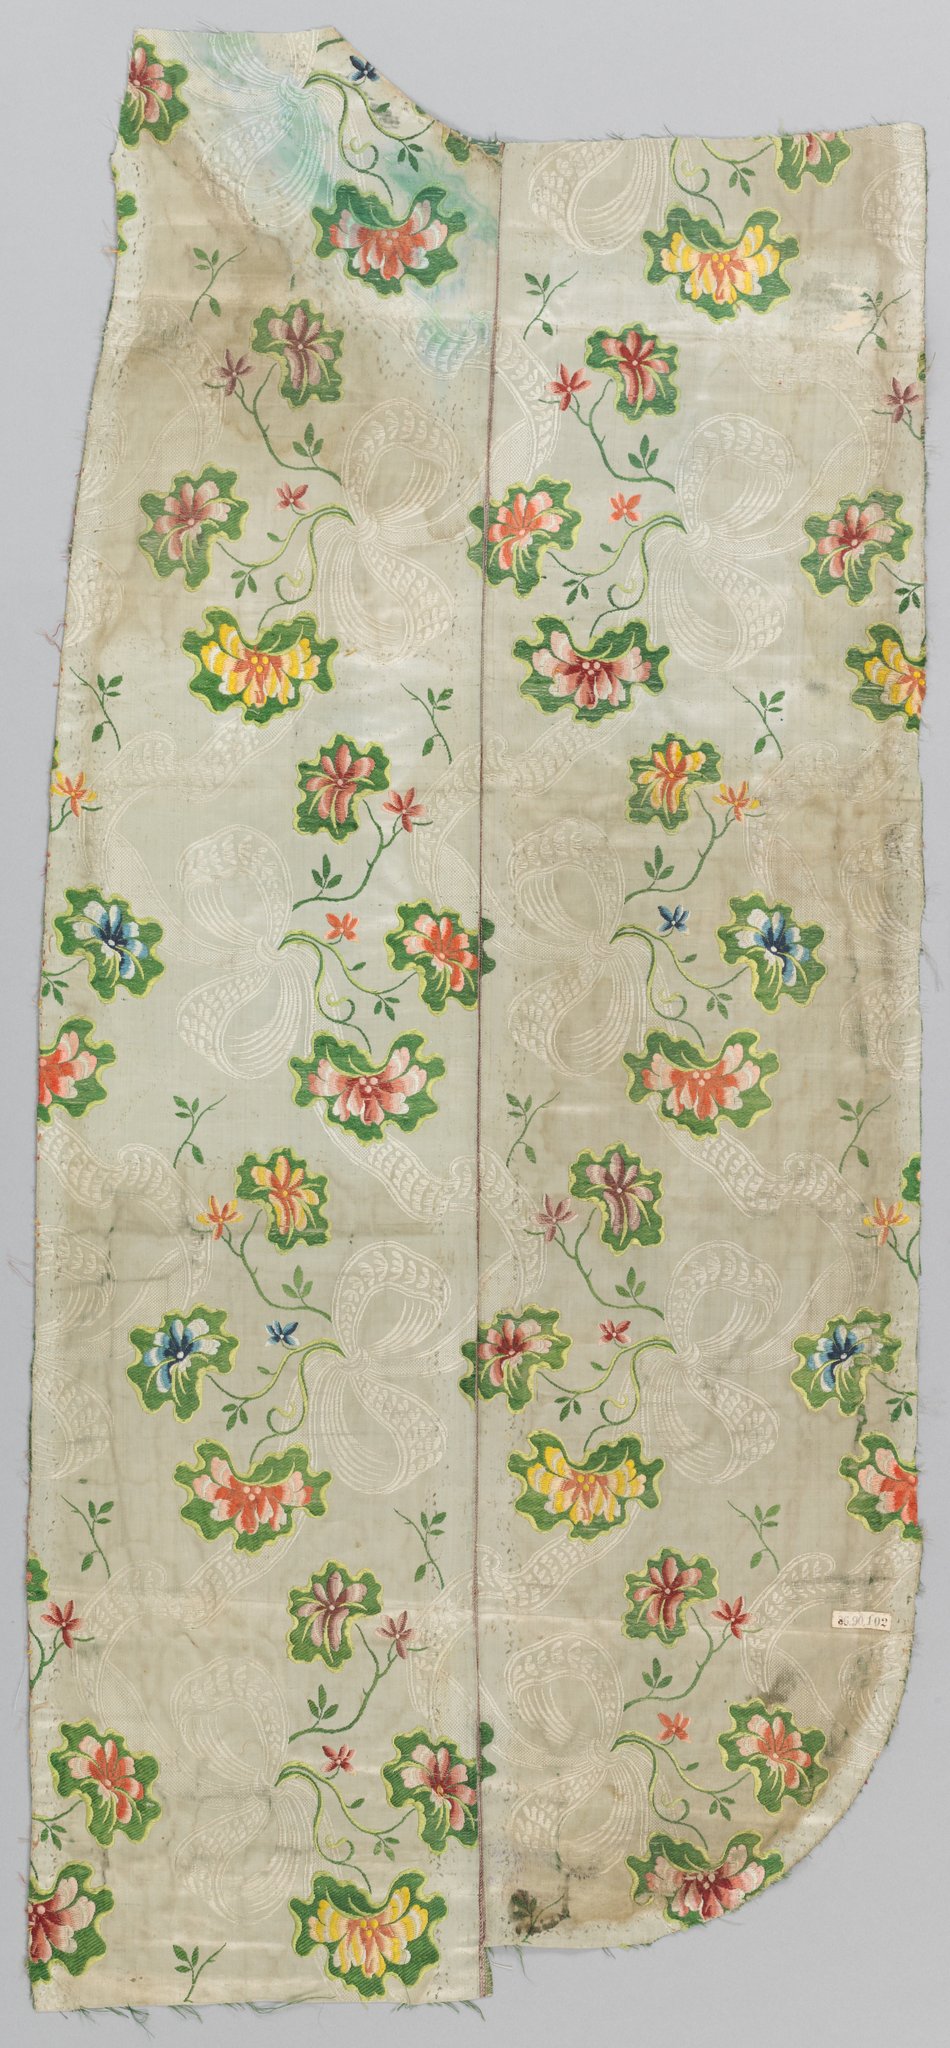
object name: piece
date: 1750-1760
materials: silk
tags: flowers